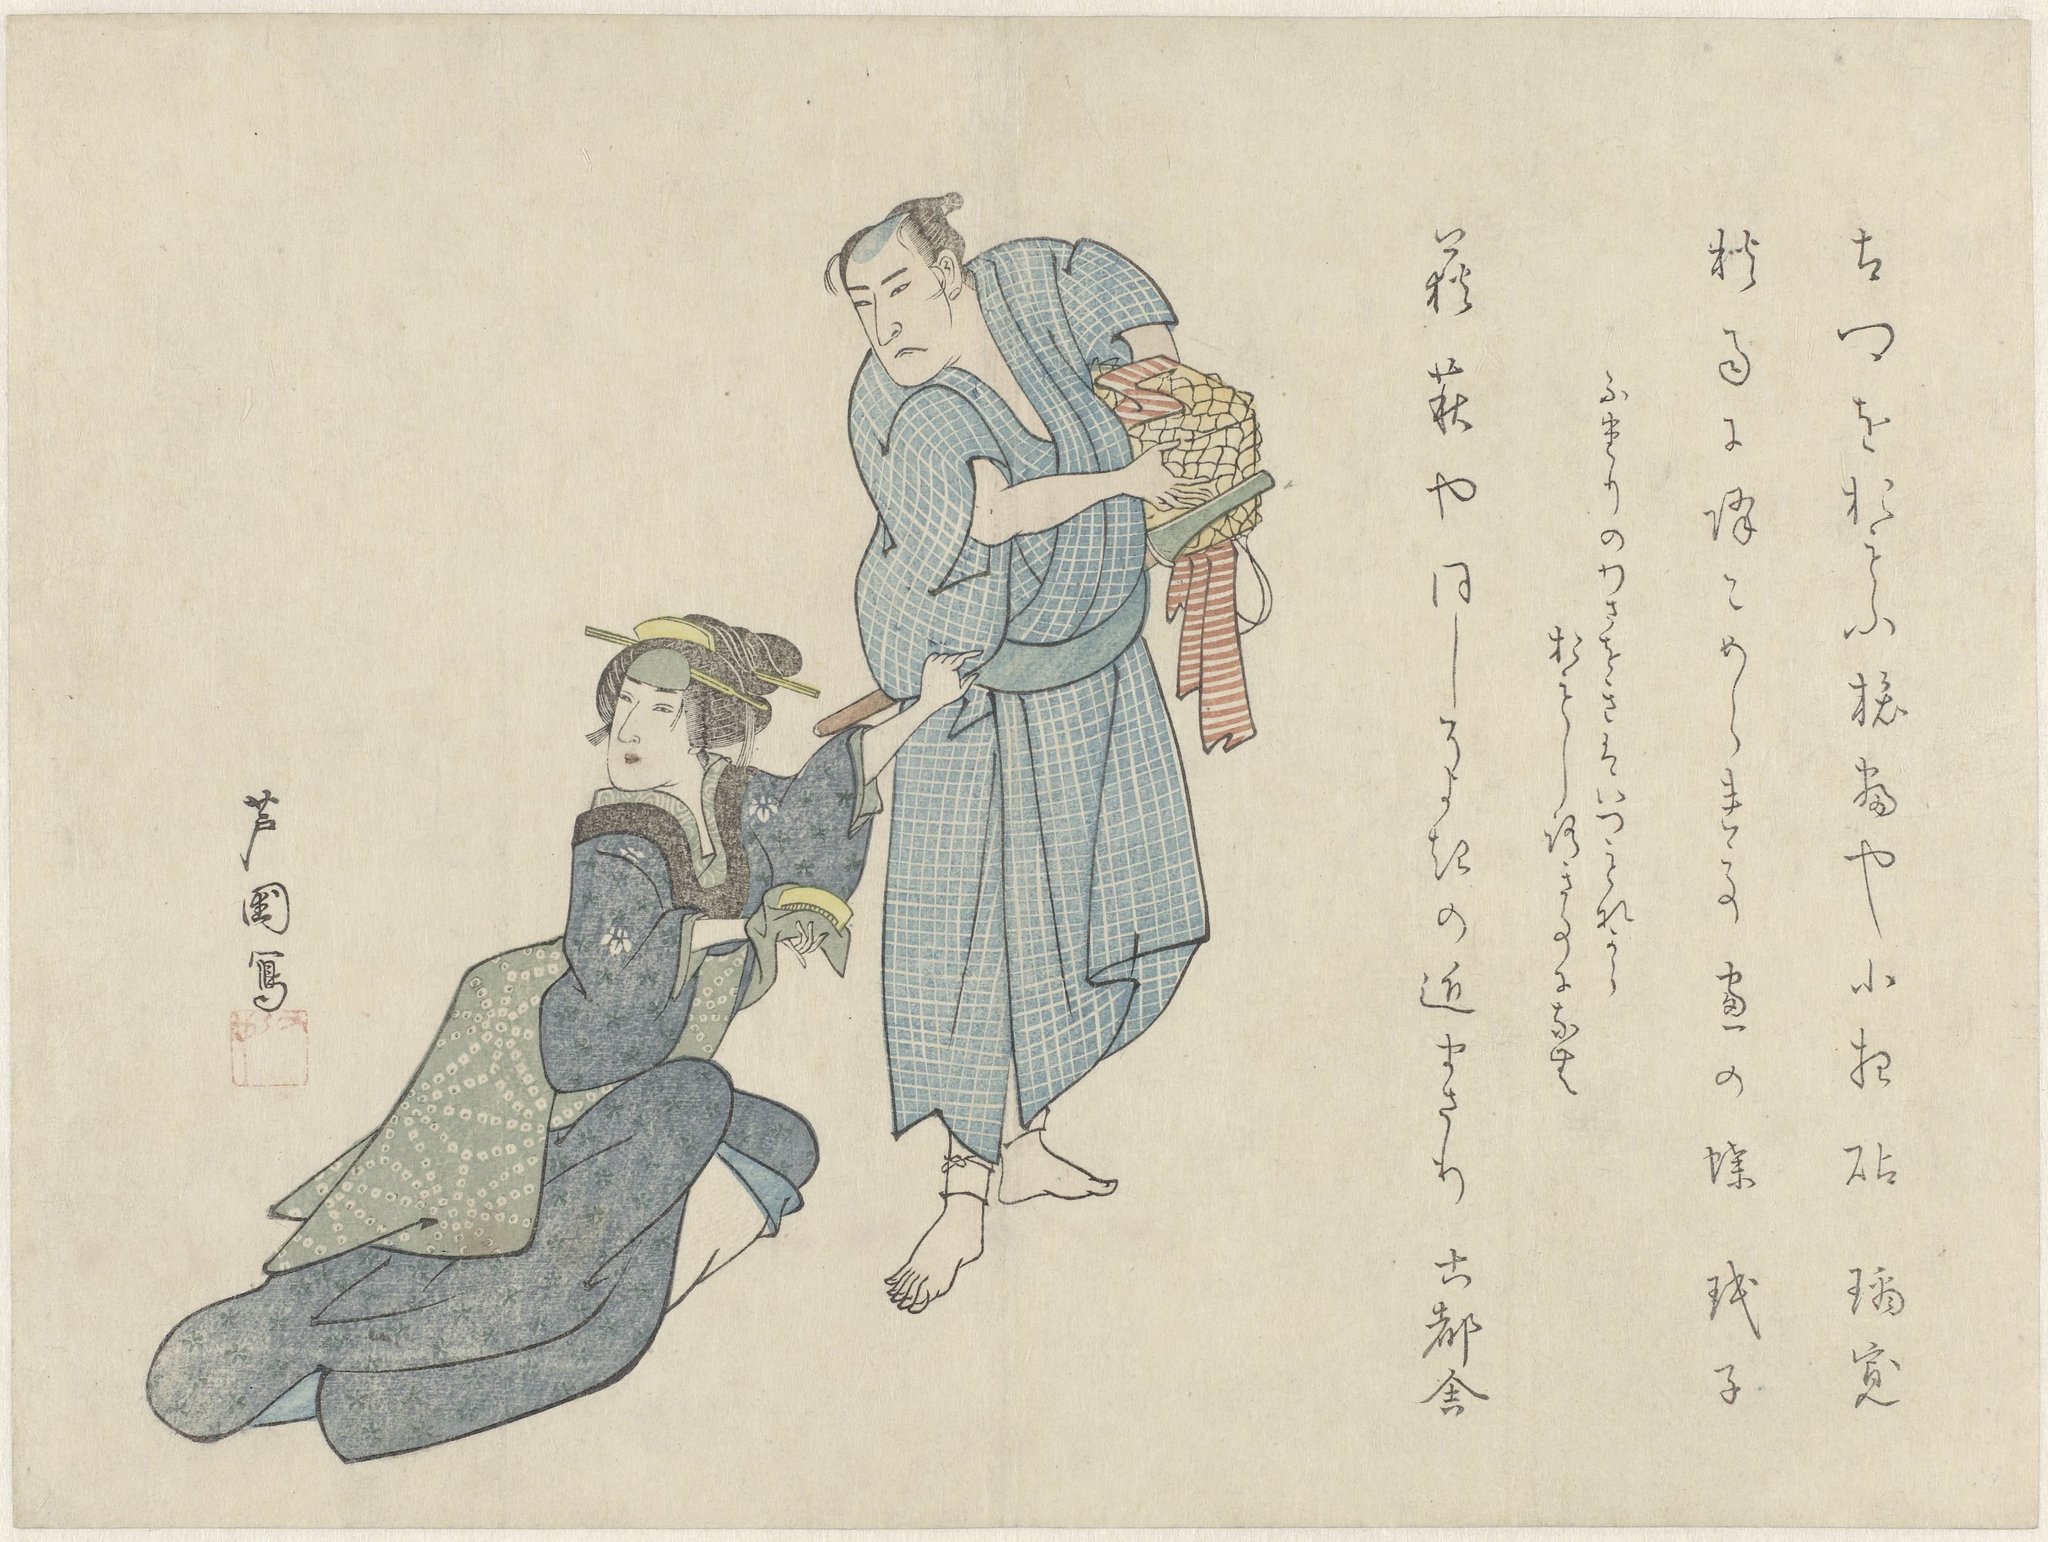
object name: print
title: Vrouw met kam in haar hand en man die mand draagt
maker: asayama ashikuni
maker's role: print maker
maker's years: 1775-1818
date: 1800-1810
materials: paper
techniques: woodcut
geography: osaka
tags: carrying something, comb, brush and other tools (care of the hair) - aa - ~ women, container made of plant material other than wood: basket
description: Osaka surimono met zittende vrouw met kam in haar hand en rechts een staande man met zwaard die een mand draagt.